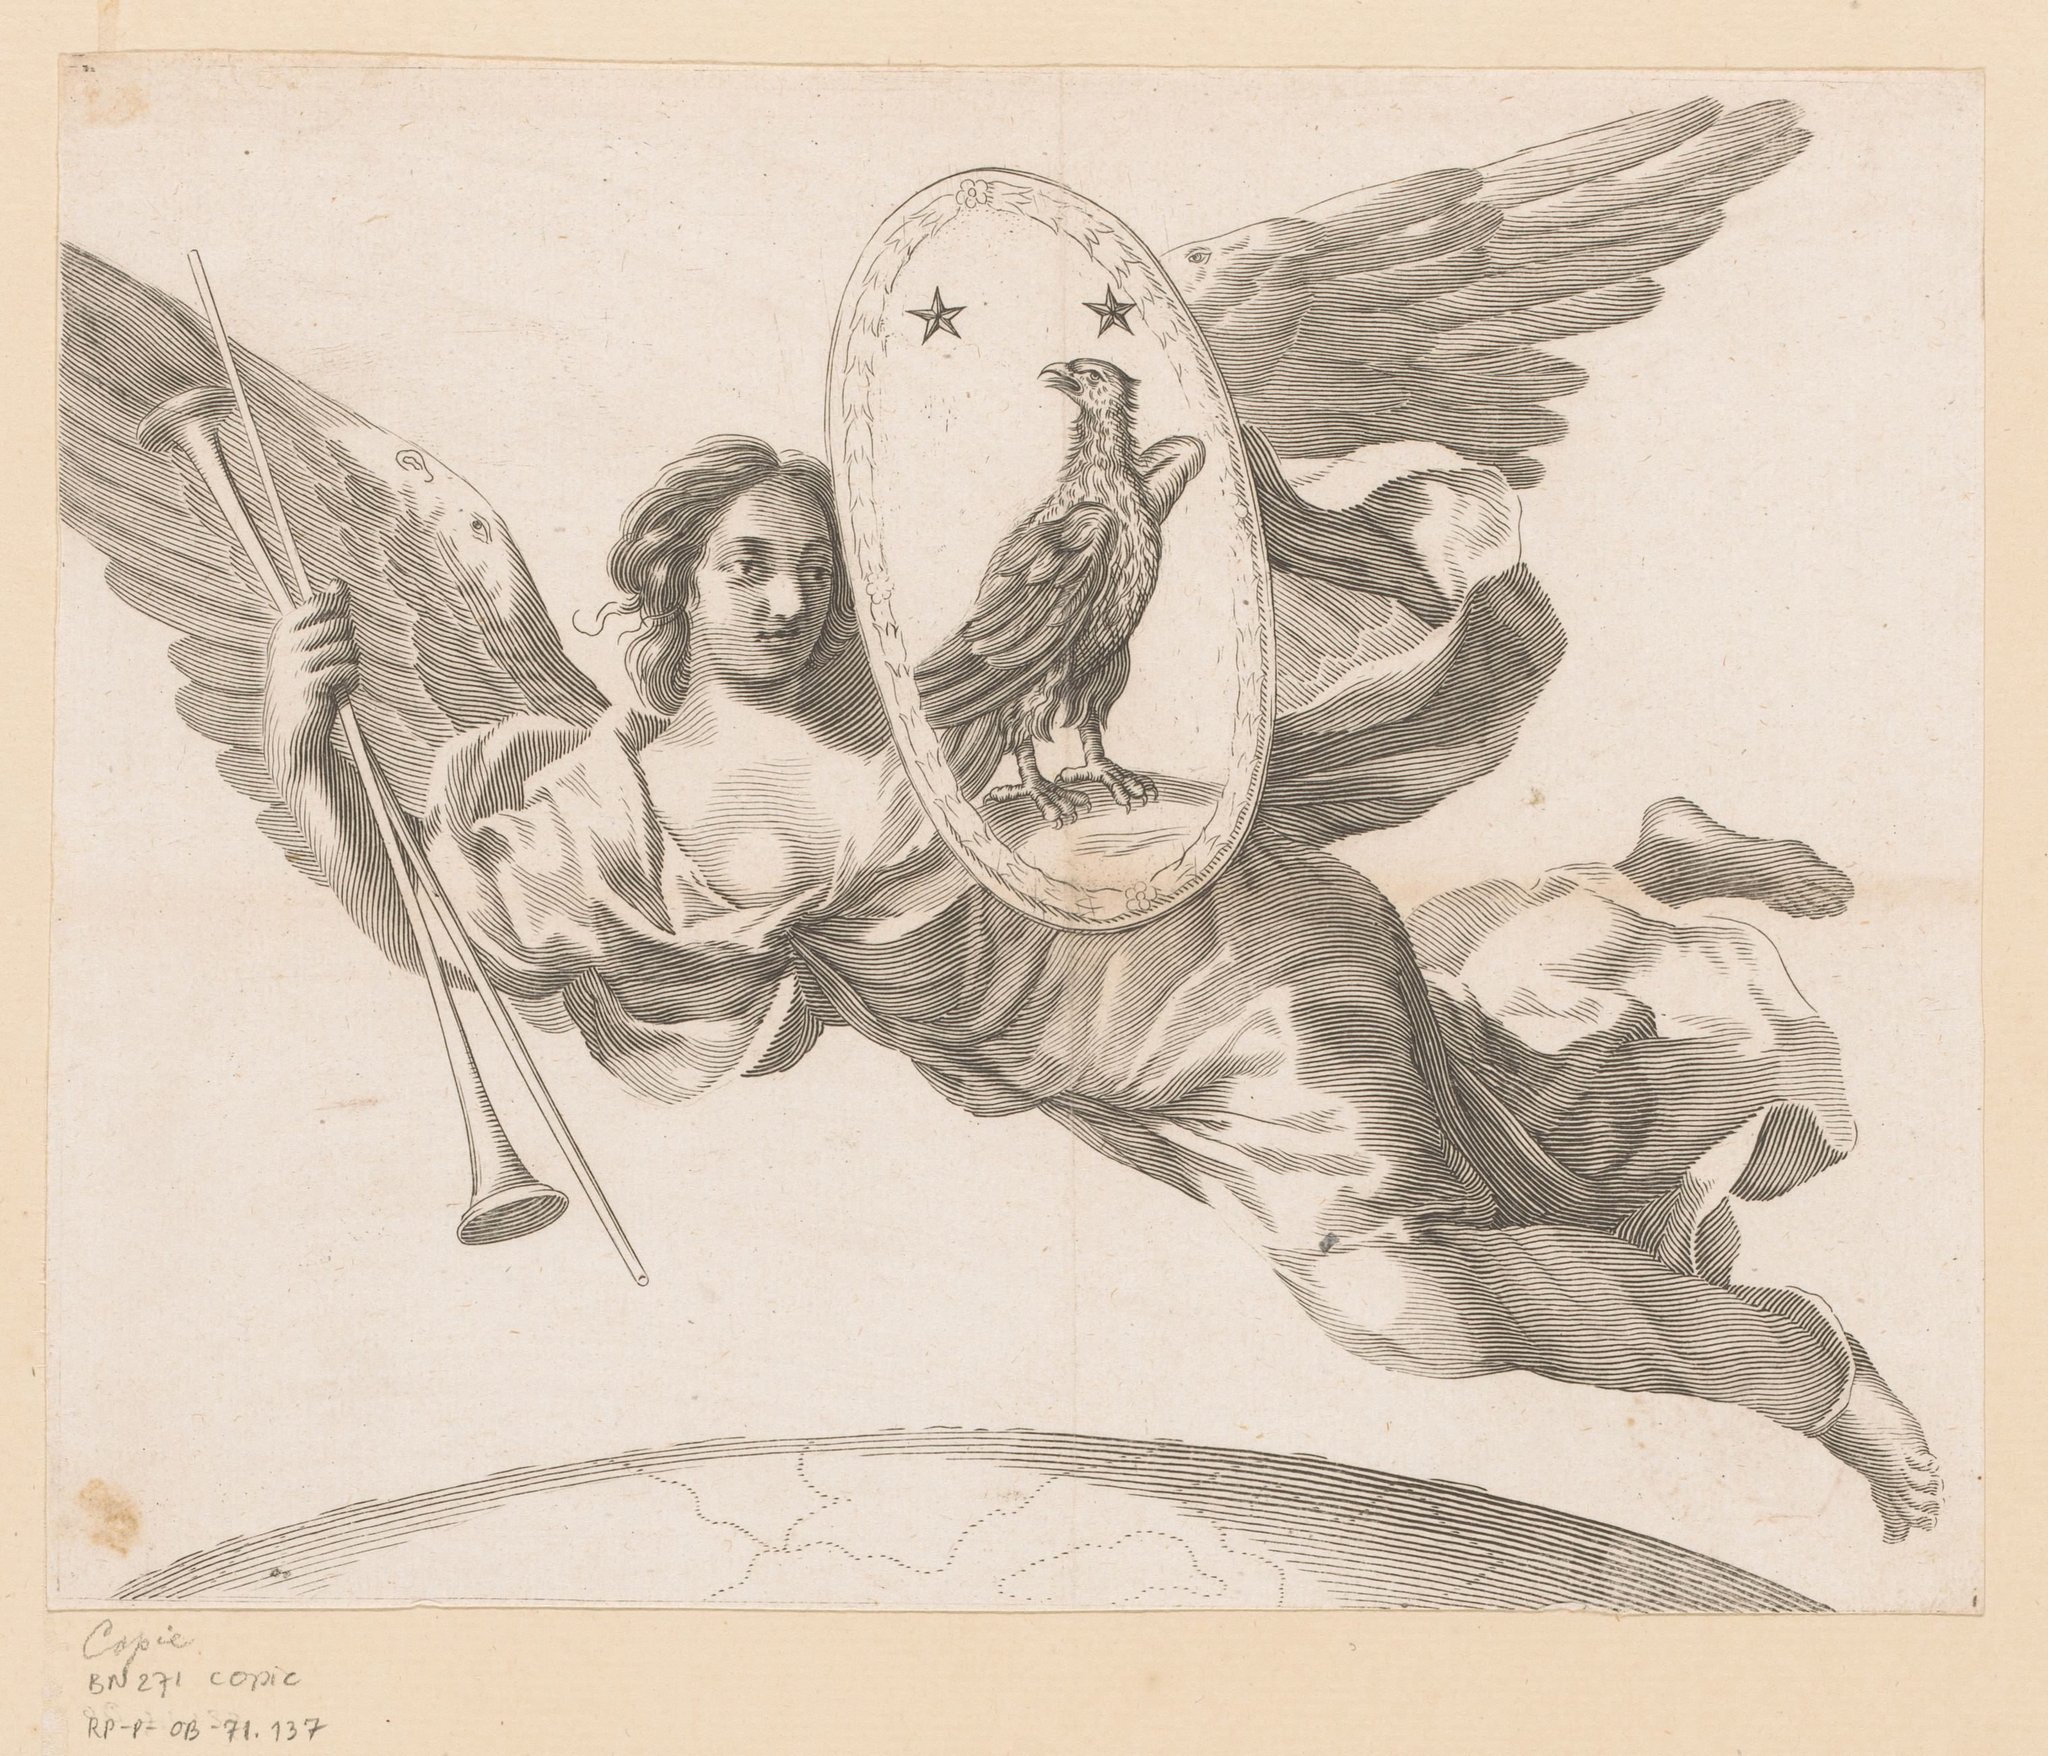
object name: print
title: Vrouwelijke figuur met vleugels en wapenschild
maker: Anonymous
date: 1608-1688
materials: paper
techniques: engraving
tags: armorial bearing, heraldry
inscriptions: collector's mark: Lugt 240